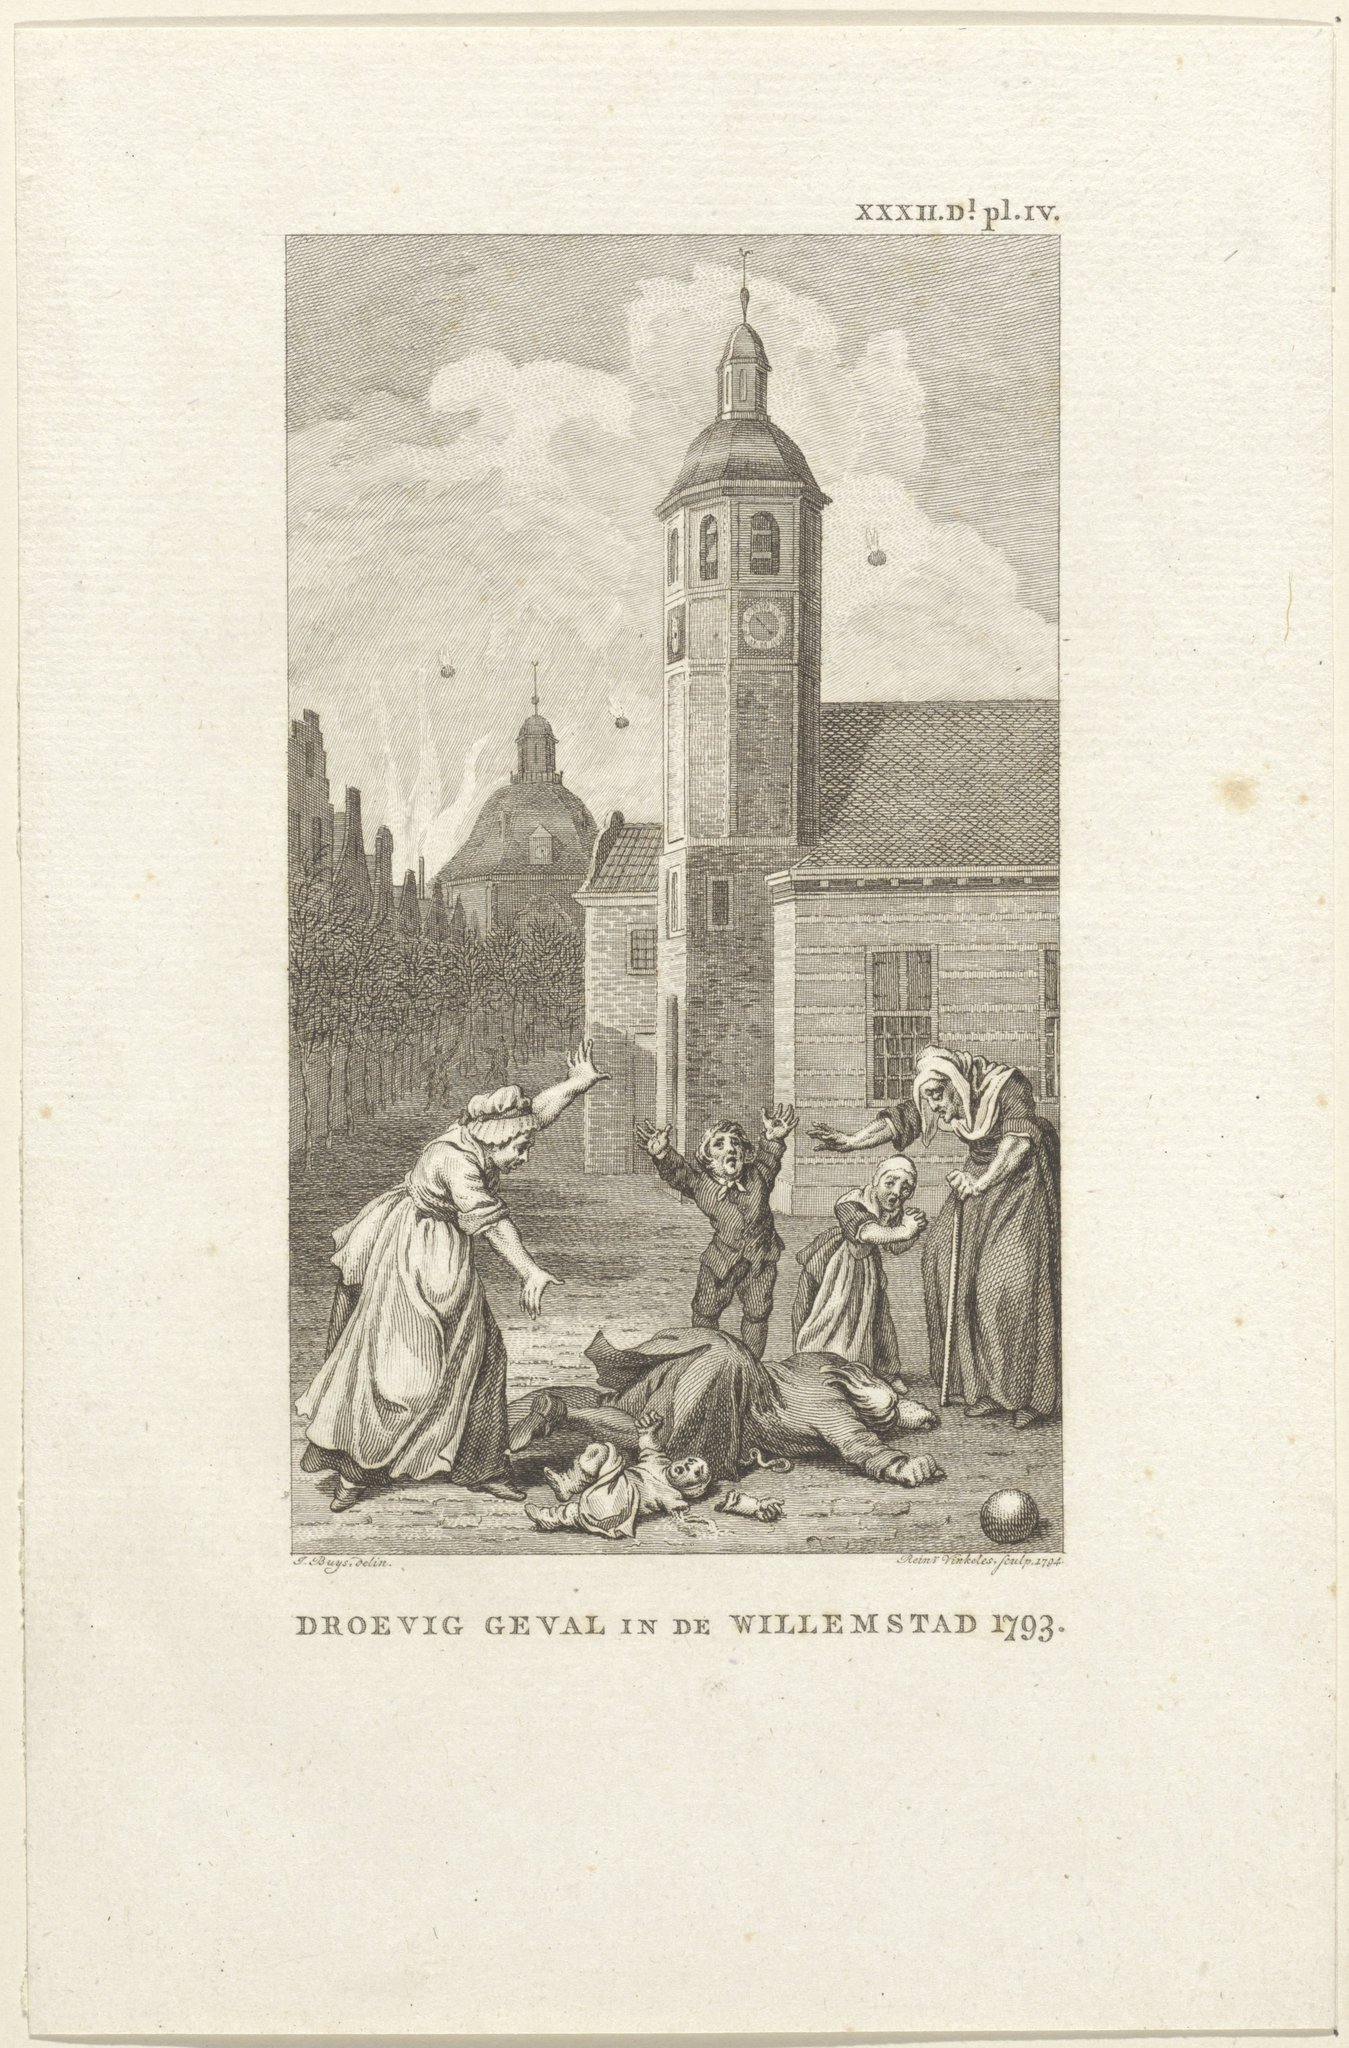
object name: print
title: Droevig geval in de Willemstad 1793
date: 1794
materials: paper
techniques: engraving, etching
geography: amsterdam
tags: civilians during bombardment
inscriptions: date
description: Een man met een klein kind worden getroffen door een Franse granaat. Op de achtergrond het stadhuis en de Koepelkerk. Tijdens het beleg van Willemstad door het Franse leger 27 februari - 15 maart 1793. Genummerd rechtsboven: XXXII.Dl.pl.IV.